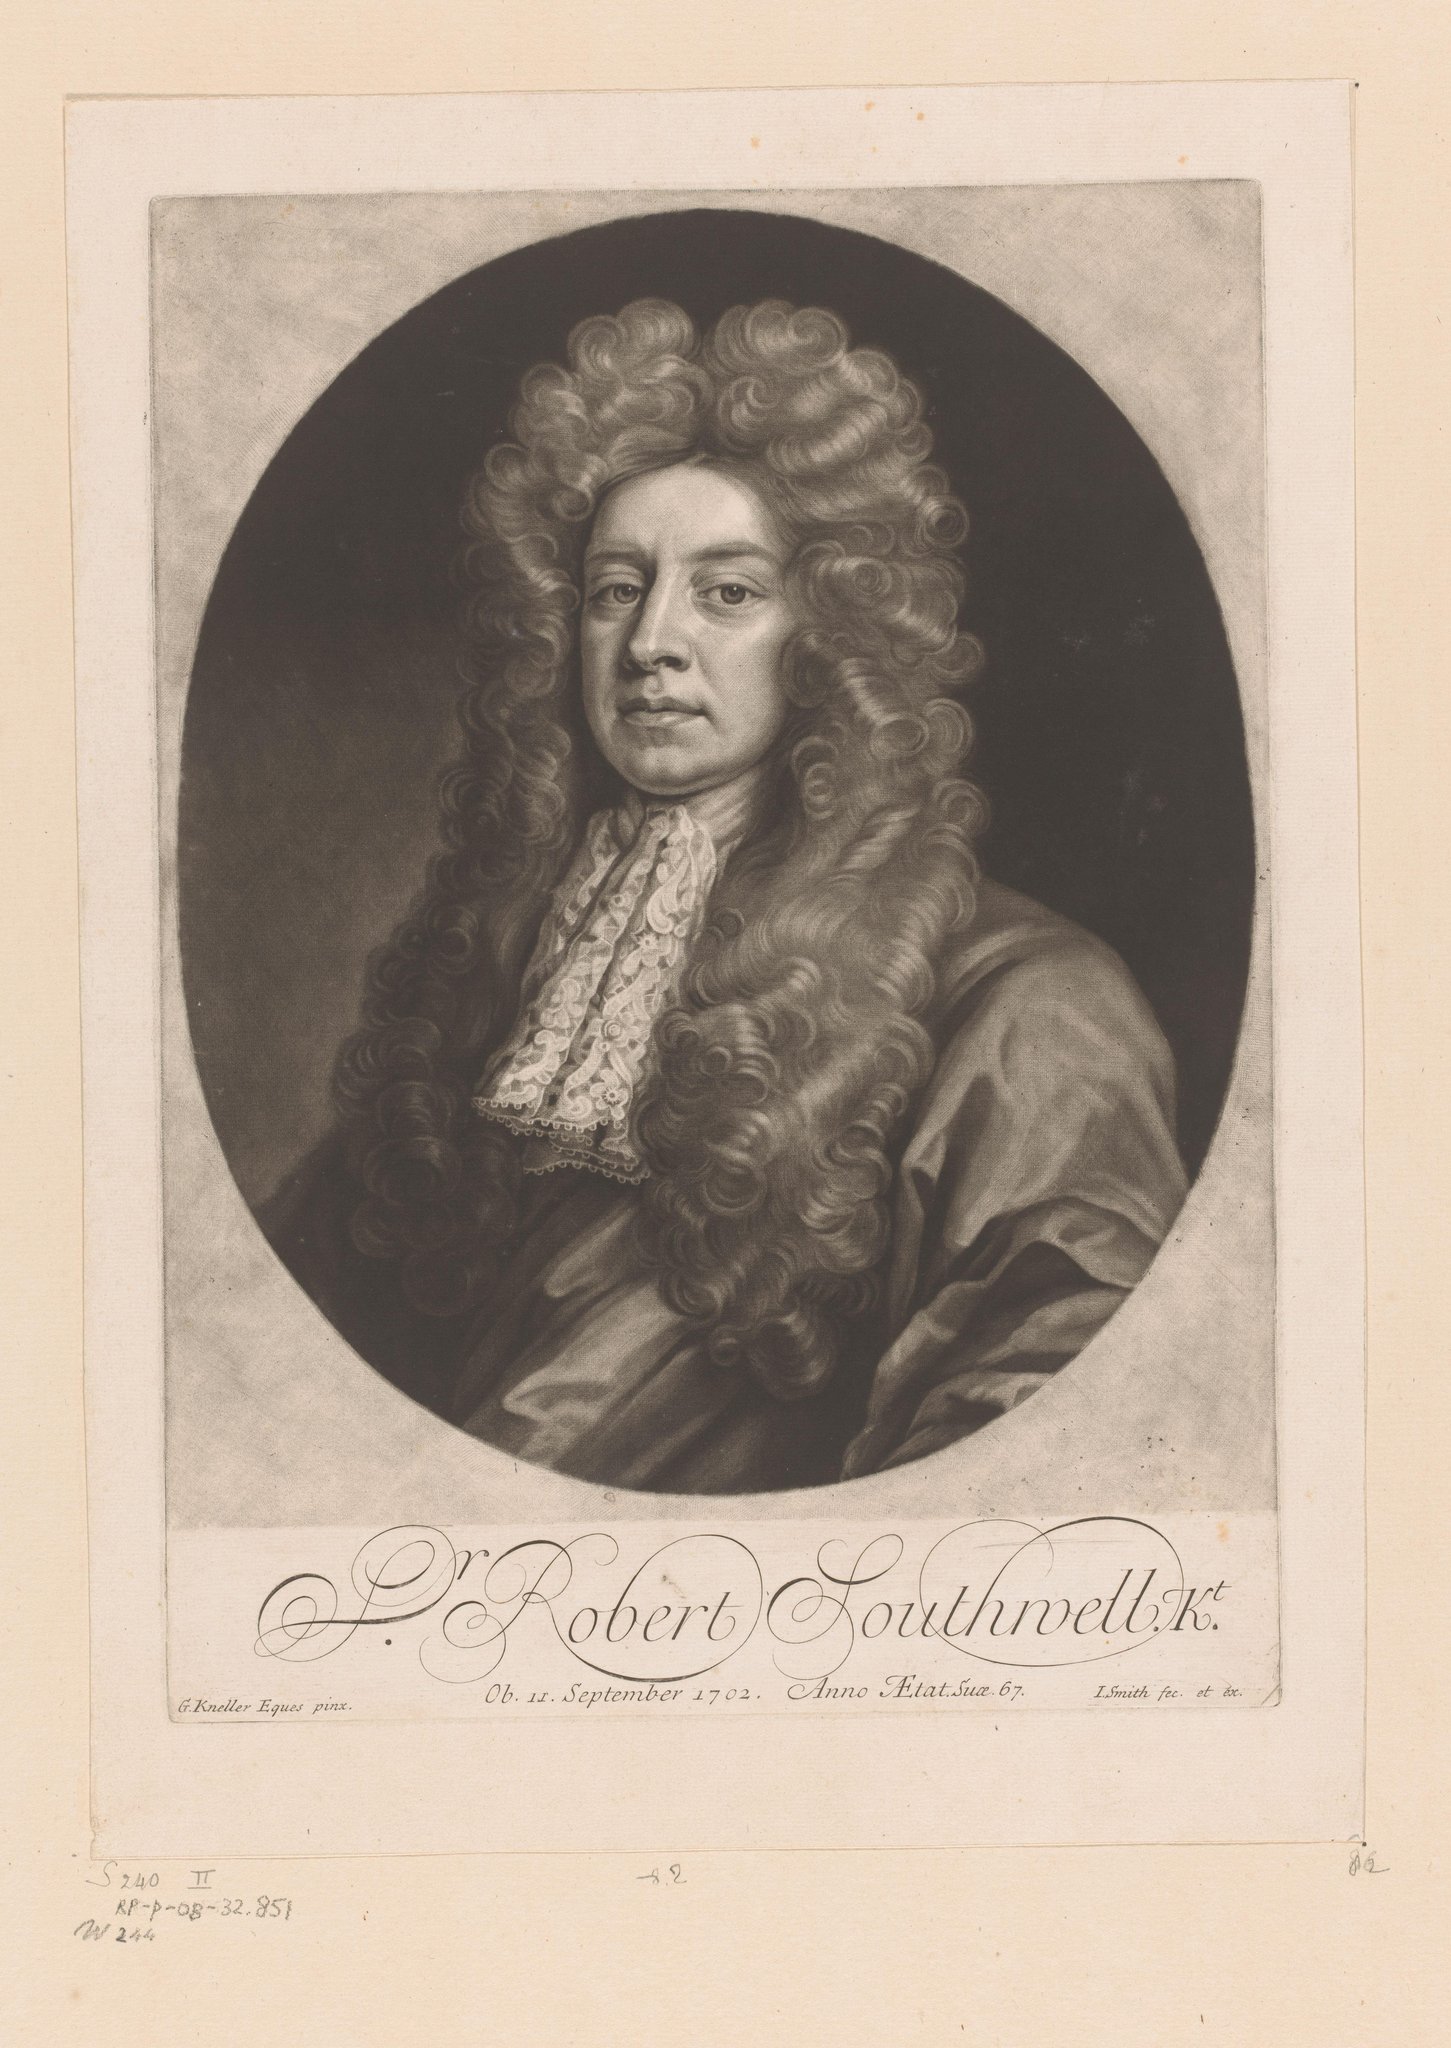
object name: print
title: Portret van Robert Southwell op 67-jarige leeftijd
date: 1702-1742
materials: paper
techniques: mezzotint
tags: historical persons, diplomacy, diplomat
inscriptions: collector's mark: Lugt 240